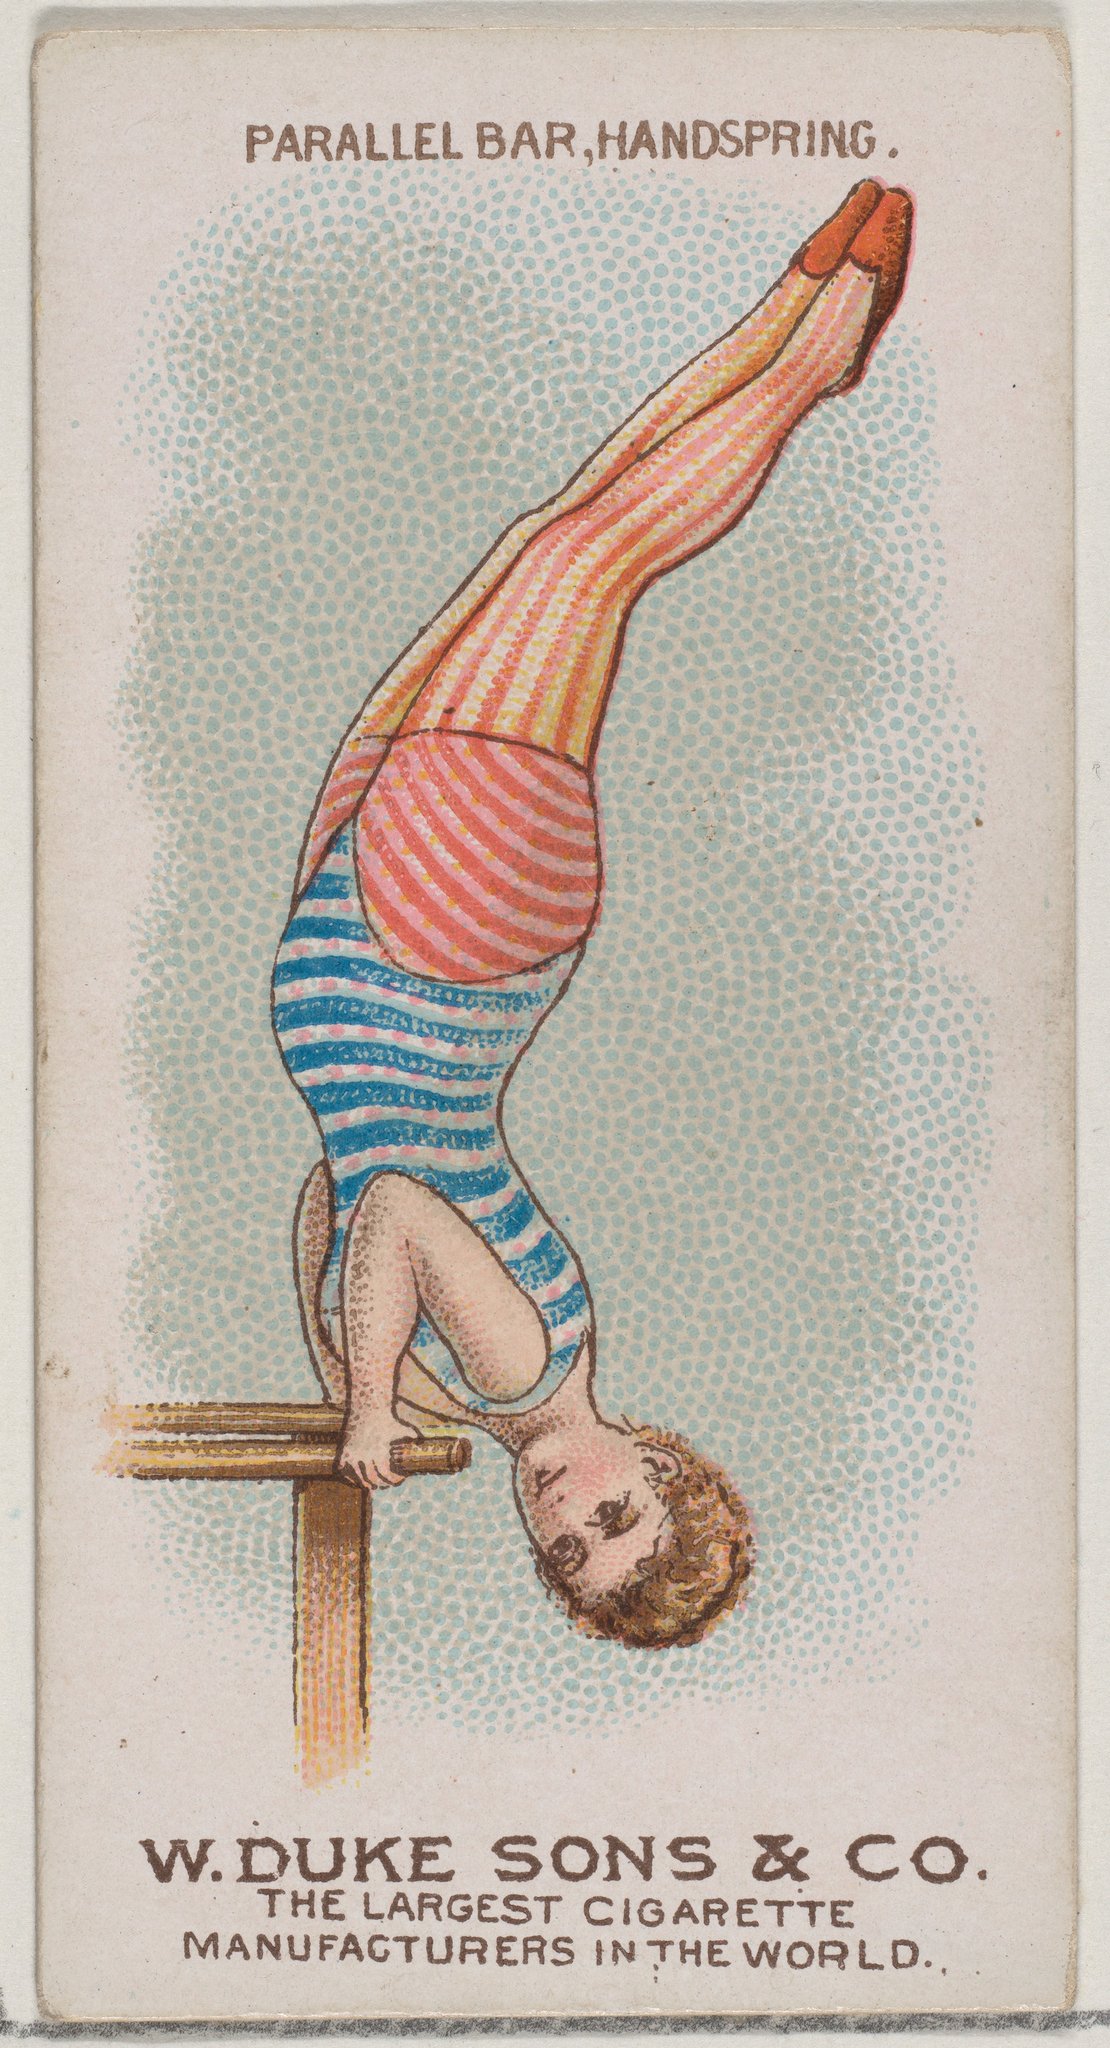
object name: print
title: Parallel Bar, Handspring, from the Gymnastic Exercises series (N77) for Duke brand cigarettes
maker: w. duke, sons & co.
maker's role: publisher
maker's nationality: american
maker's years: 1870-1920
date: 1887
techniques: color lithograph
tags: women,sports,athletes